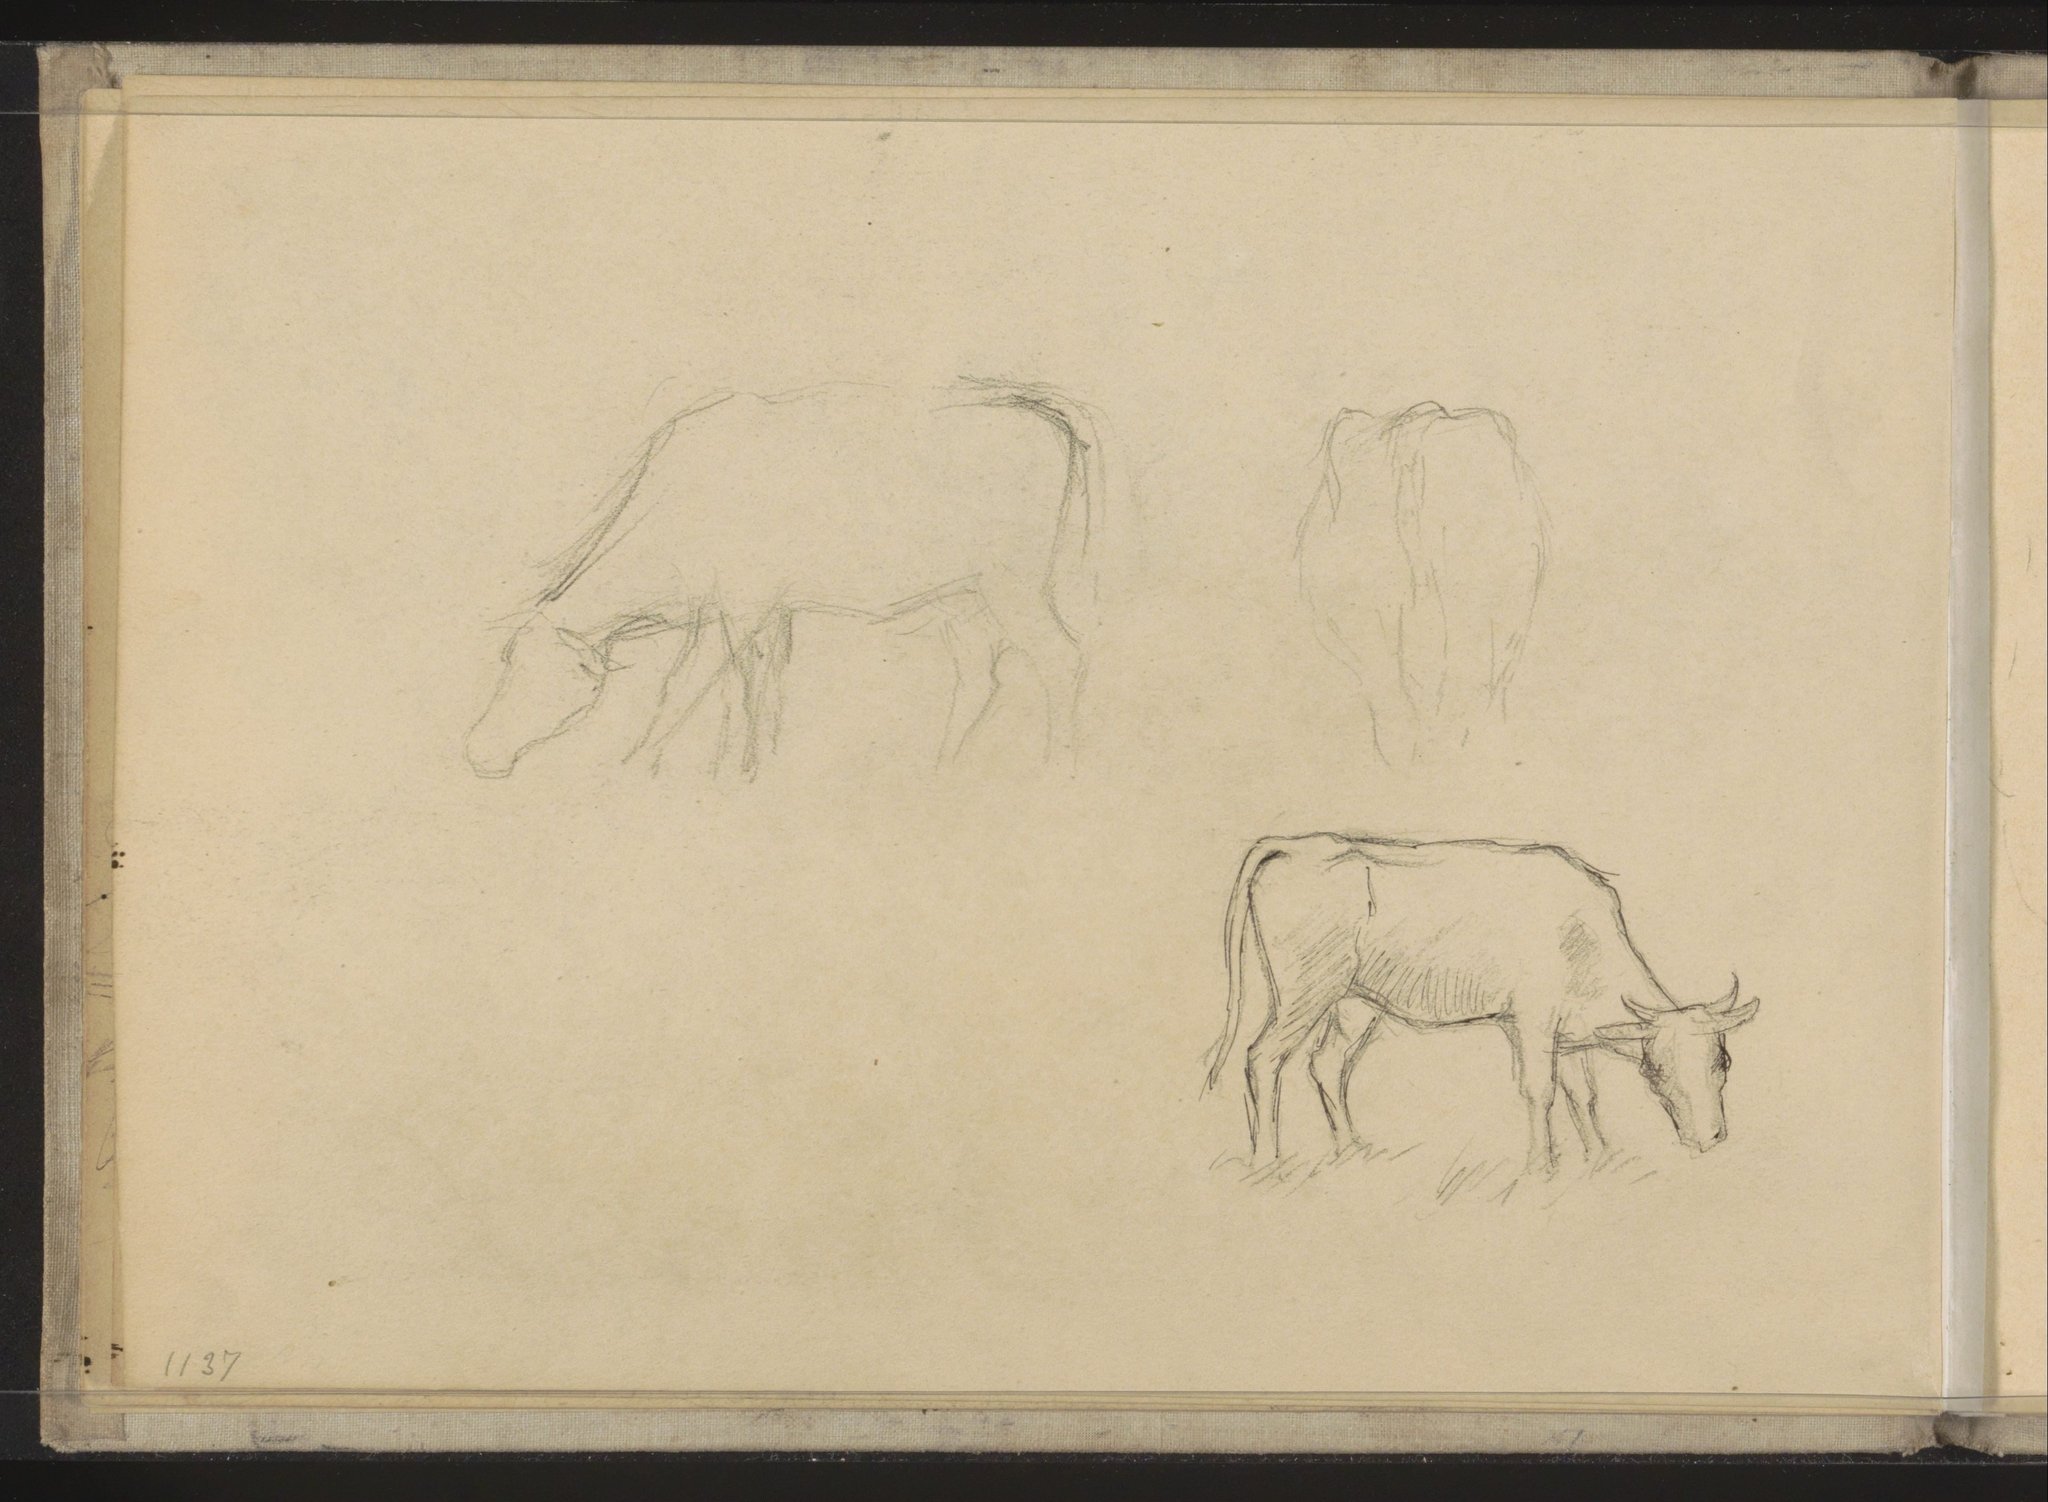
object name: sketchbook leaf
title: Grazende koeien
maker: jozef israëls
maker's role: draughtsman, painter, print maker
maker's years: 1824-1911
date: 1834-1911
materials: ink, paper, pencil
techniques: pen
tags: cow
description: Blad 7 verso uit een schetsboek met 18 bladen.